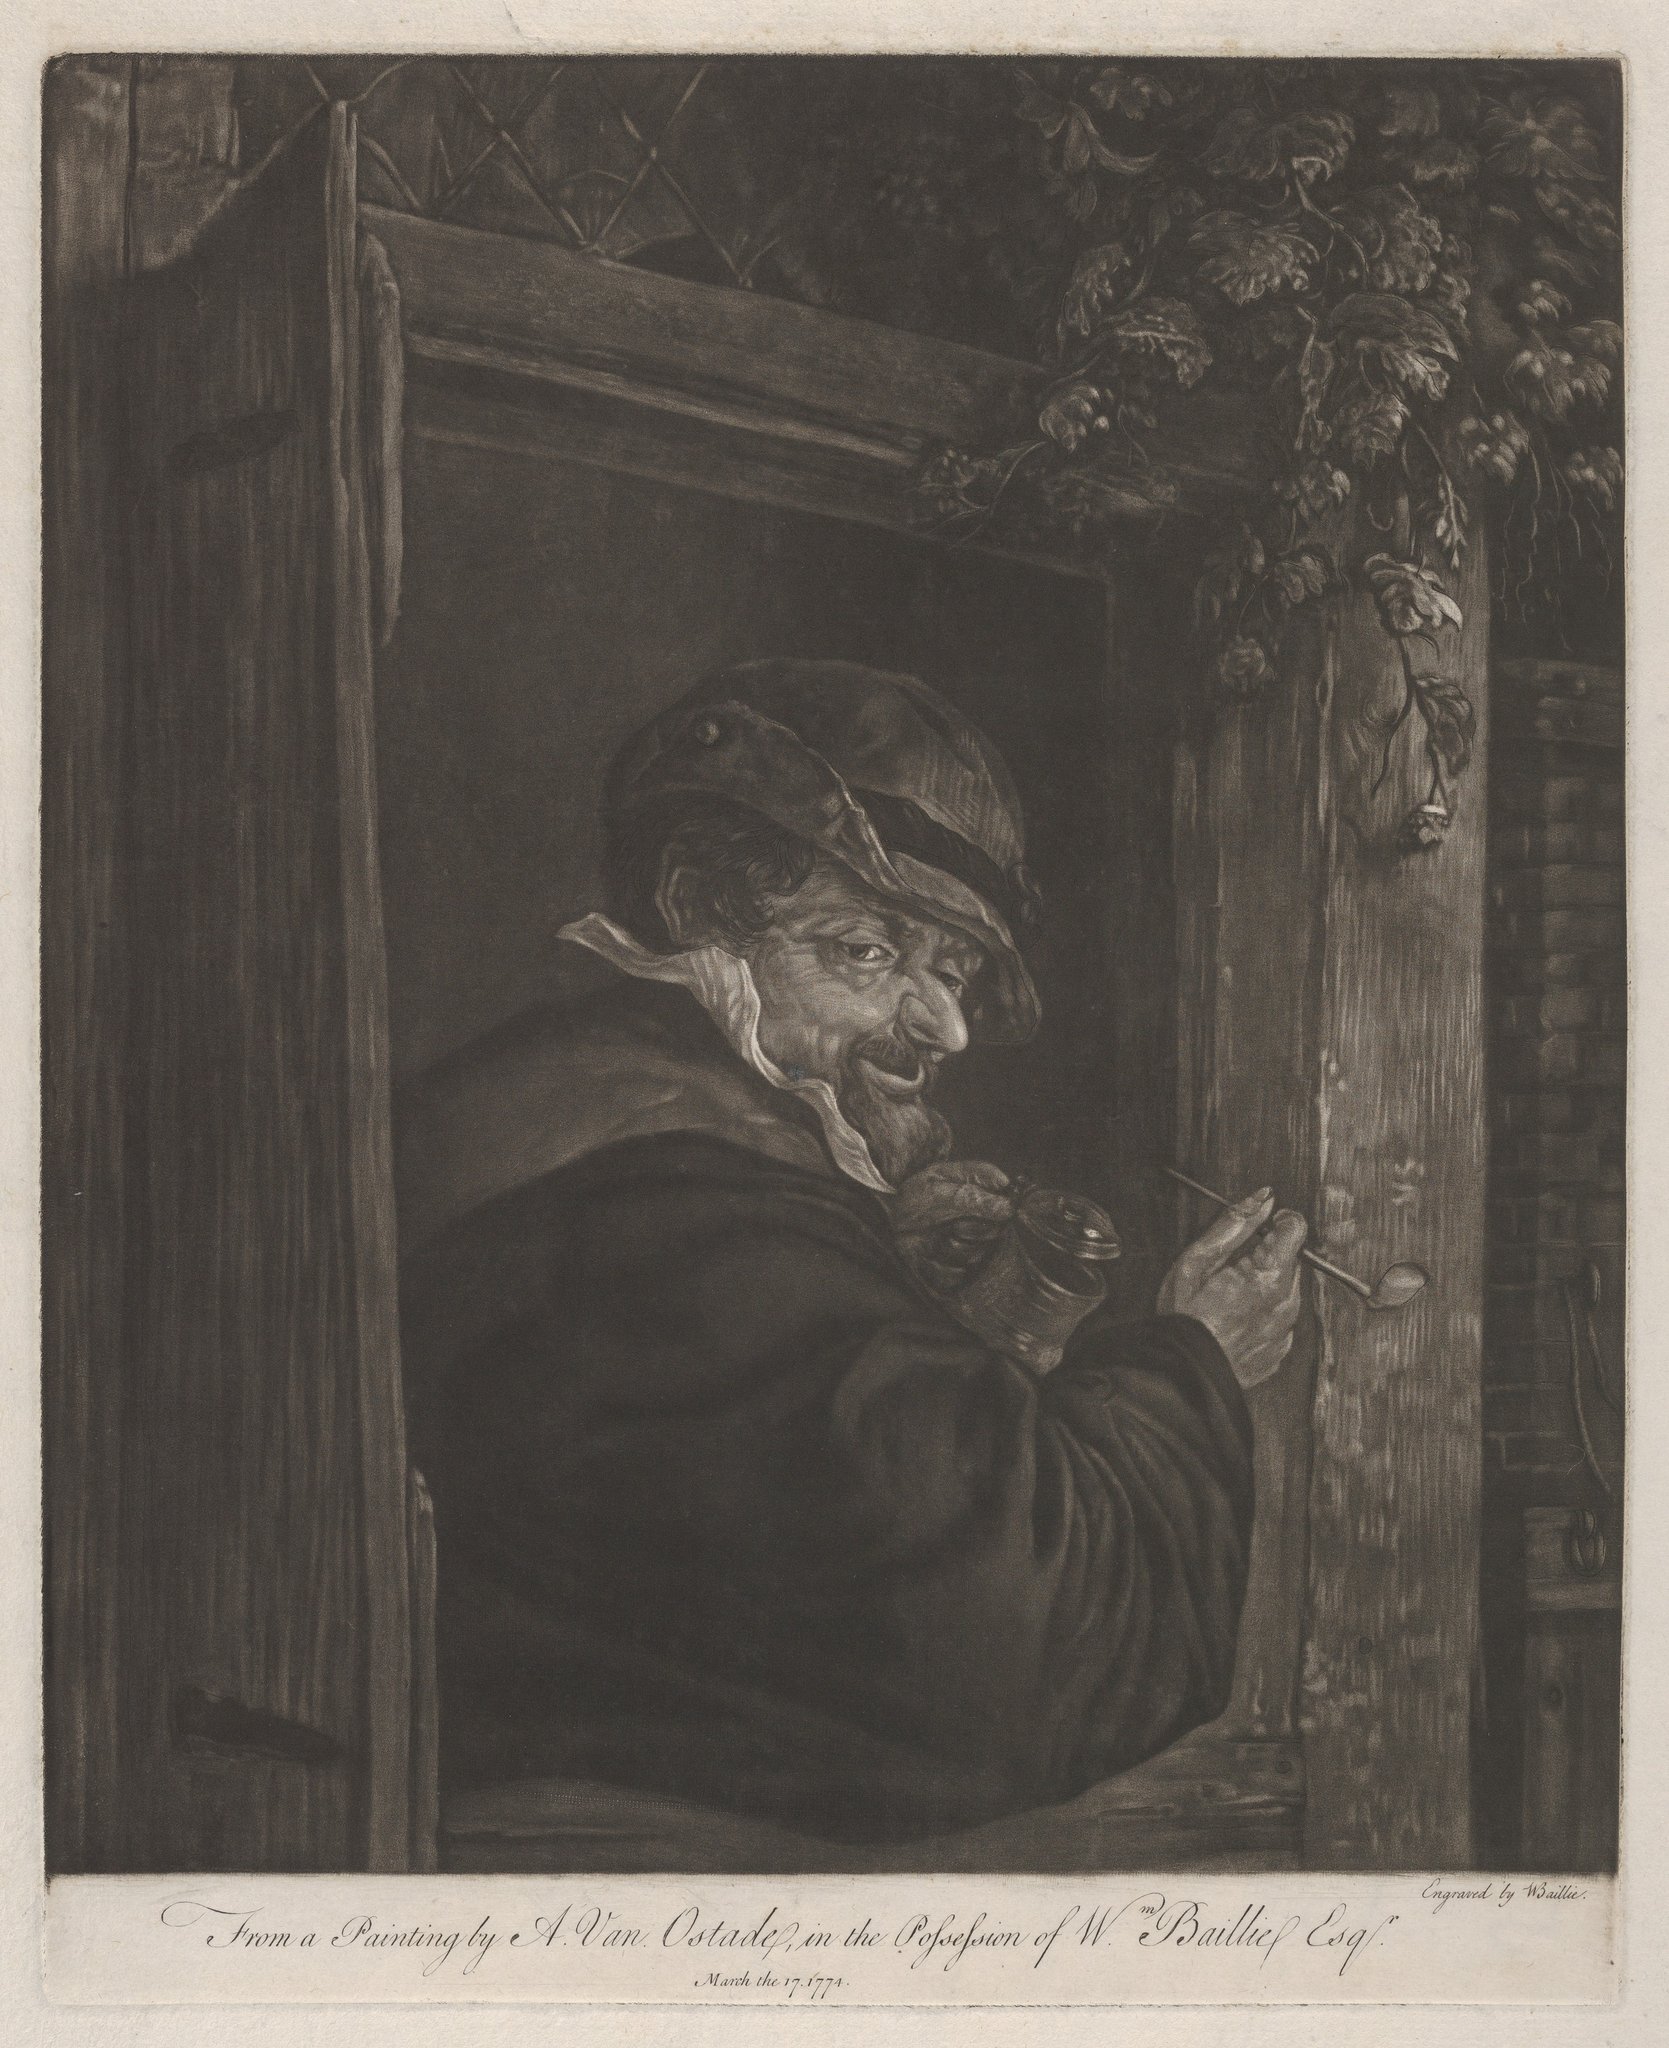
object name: print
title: Man Smoking and Drinking at a Window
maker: william baillie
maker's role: artist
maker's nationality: irish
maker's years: 1723-1810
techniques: etching, mezzotint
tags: windows,men,smoking,drinking